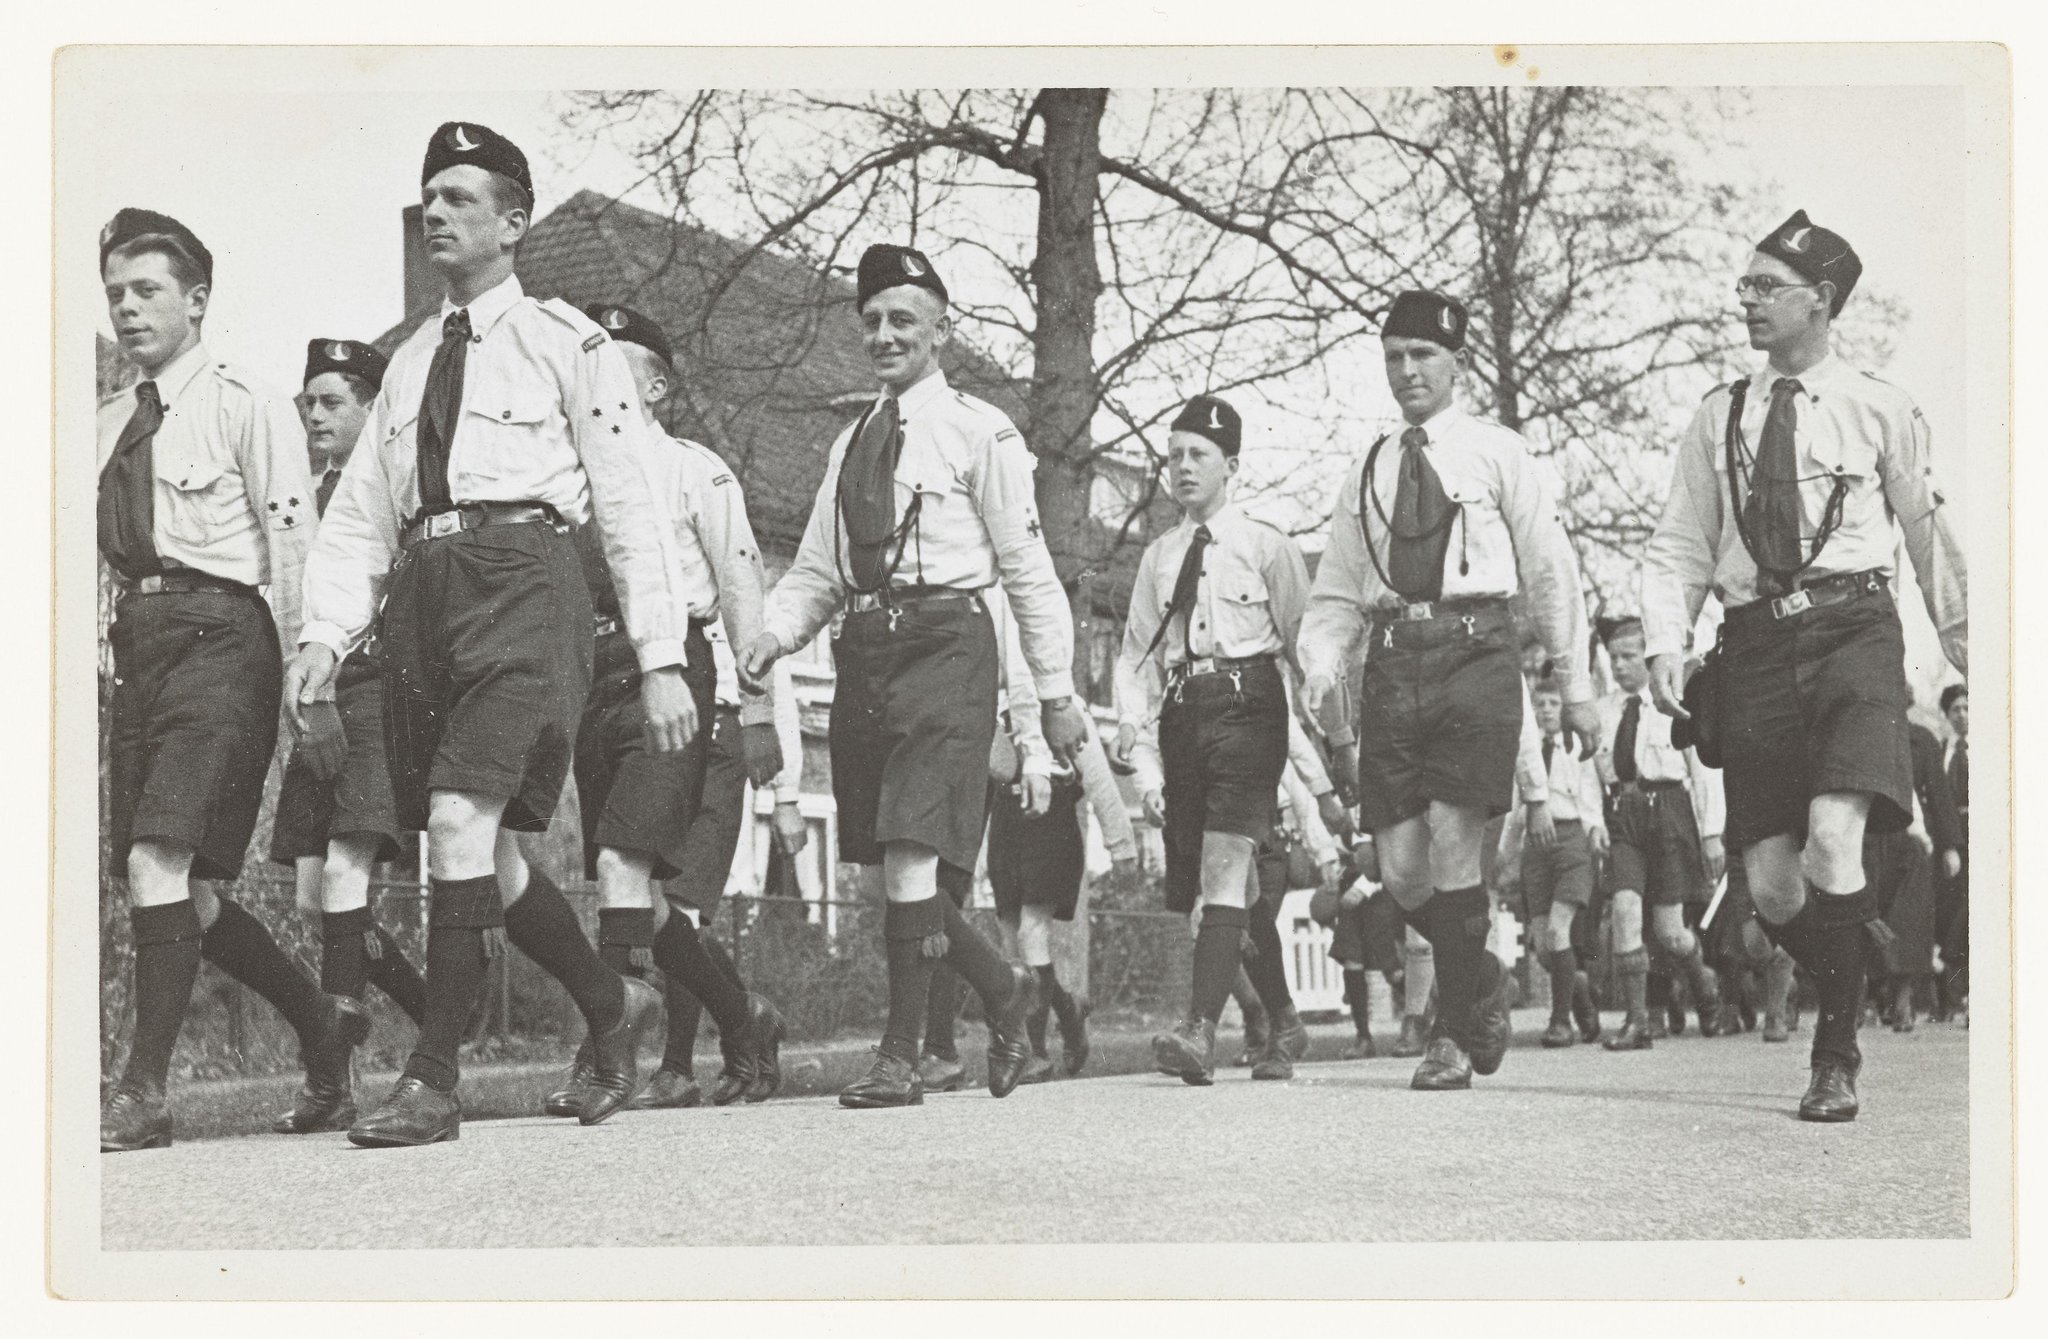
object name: photograph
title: Jeugdstorm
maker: j. otto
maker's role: fotograaf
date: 1935-1937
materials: photographic support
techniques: gelatin silver print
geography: zeist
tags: military parade, pageant, zeist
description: Groep van de Jeugdstorm loopt door een straat. Er zijn voornamelijk volwassen leden van de Jeugdstorm te zien, dezelfde als op foto NG-2007-35-32. De volwassenen in de leiding hadden veelal titels ontleent aan de padvinderij, zoals vaandrig en hopman.